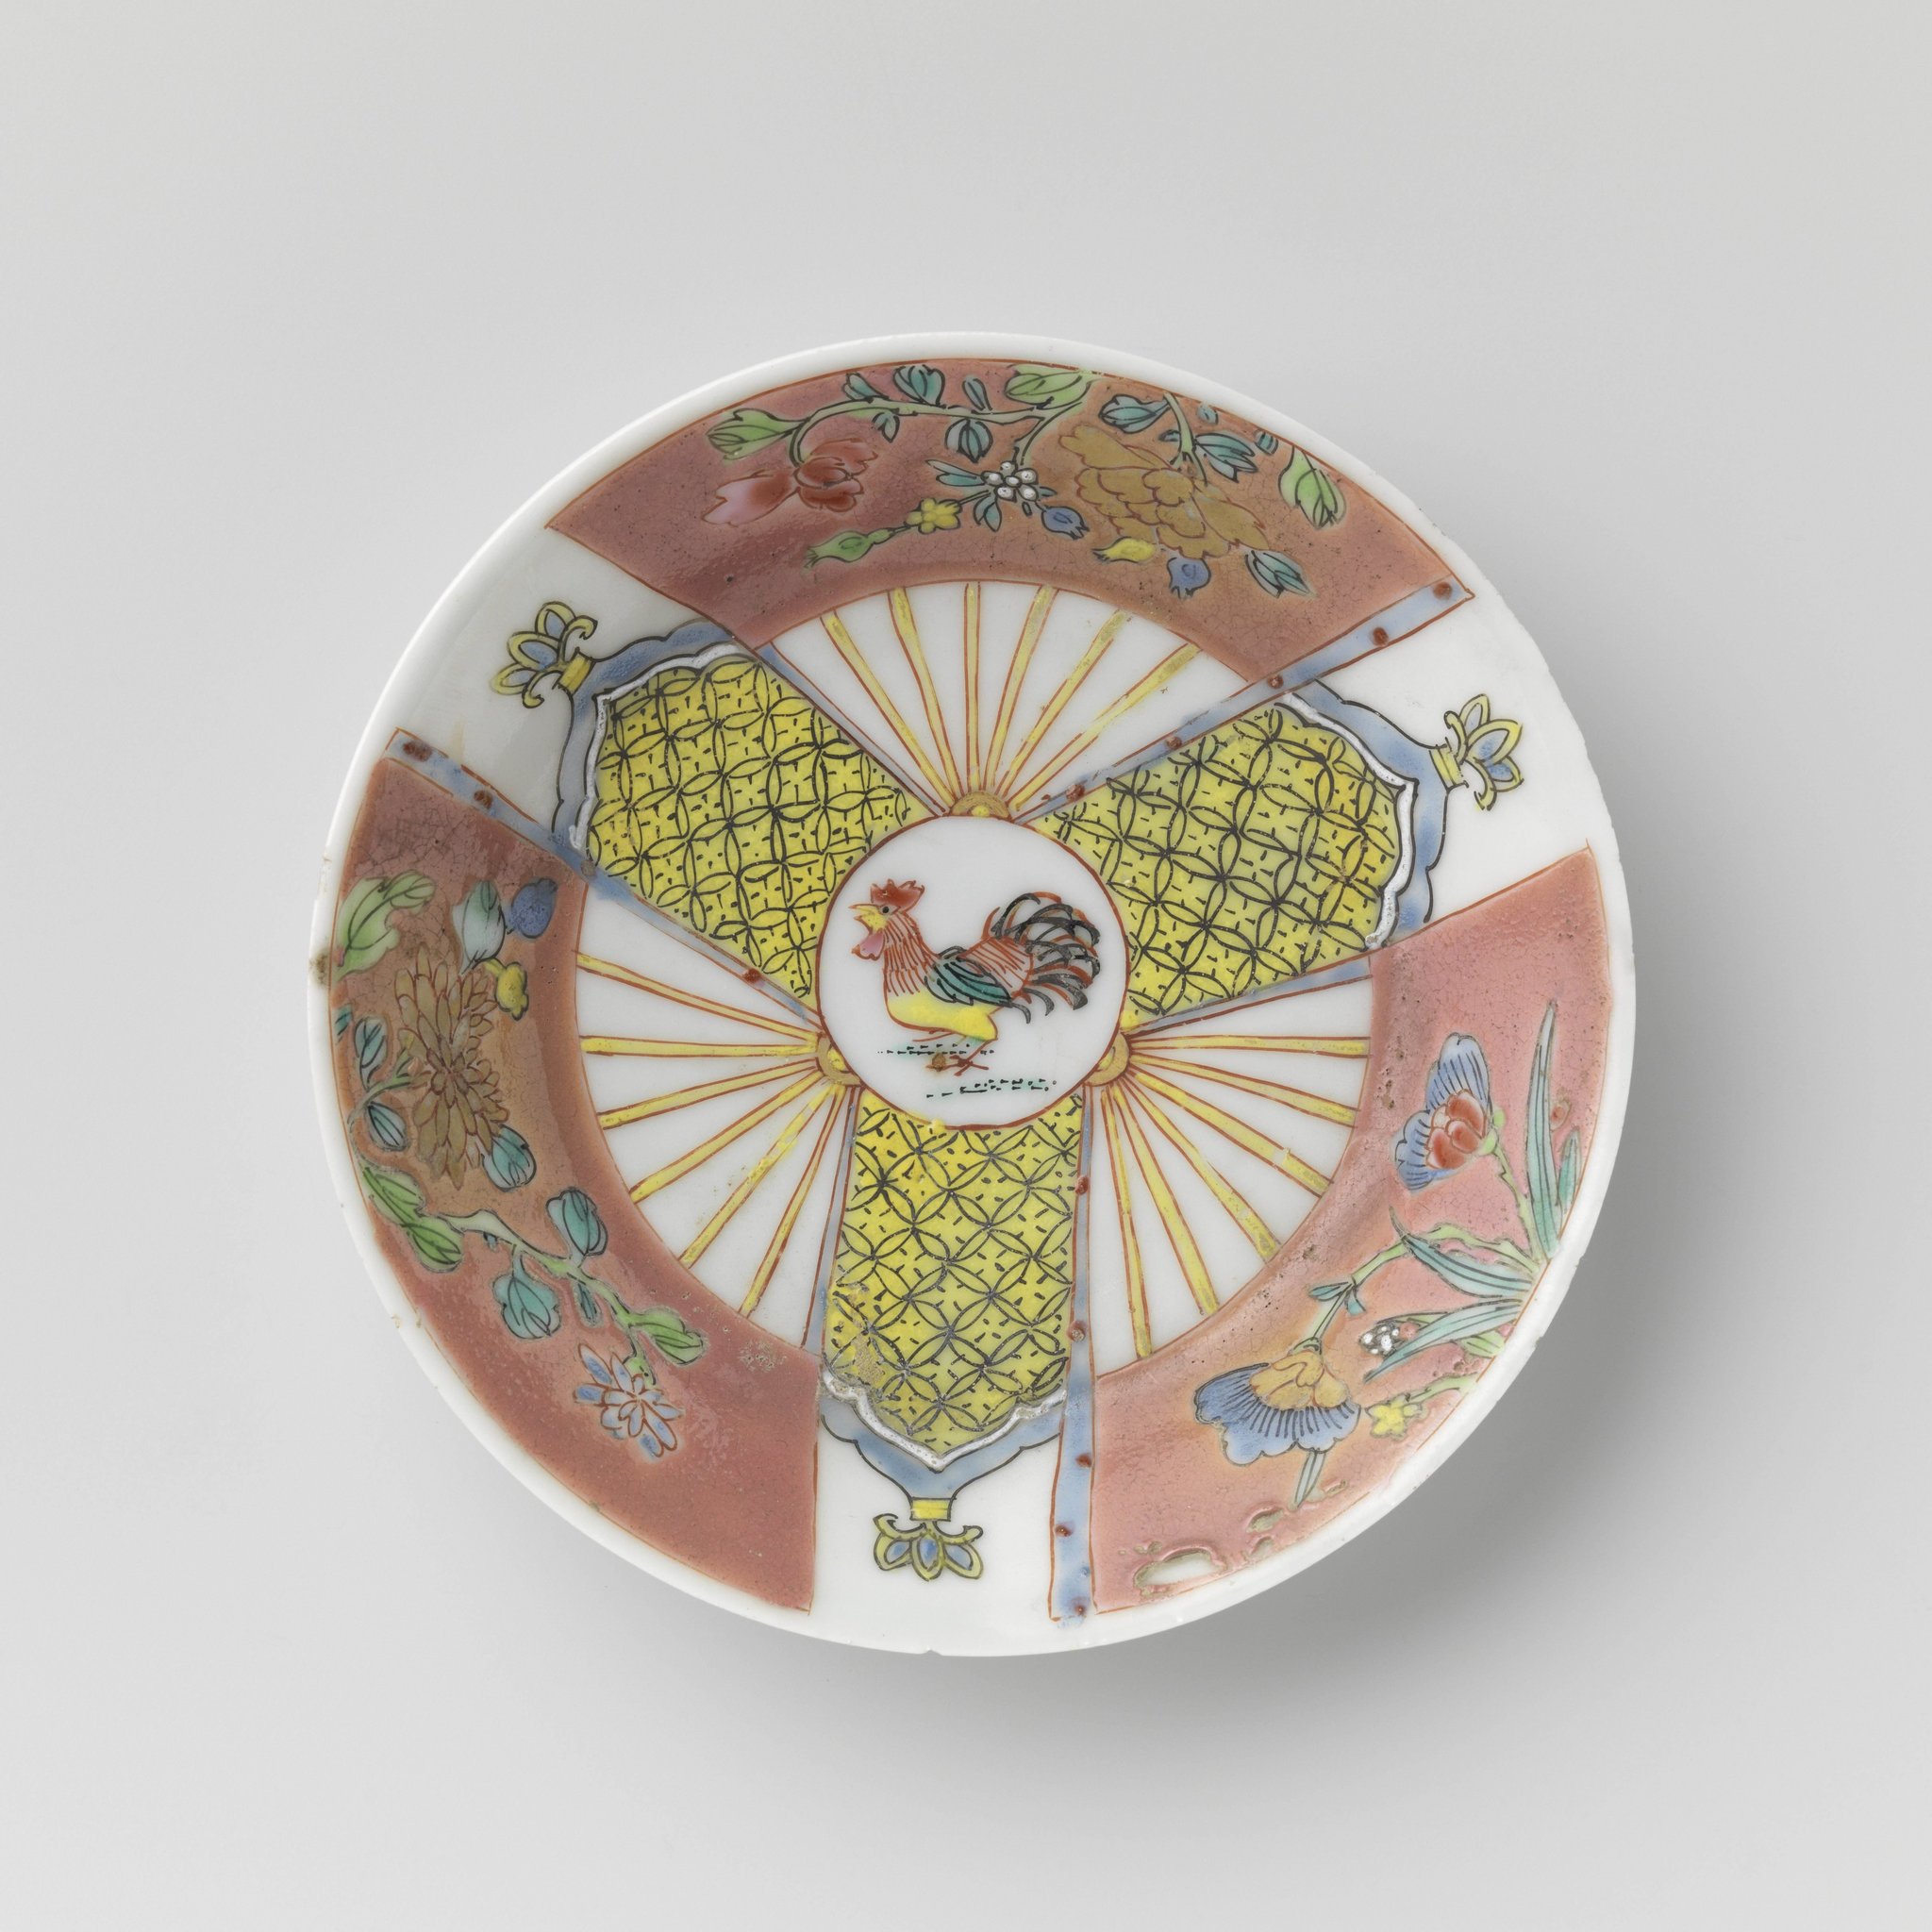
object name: kop en schotel, kop en schotel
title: Saucer with cock and three fans with flower sprays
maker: Anonymous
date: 1725-1749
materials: glaze, gold, paint, porcelain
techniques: firing, gilding, turning, vitrification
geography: china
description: Kop en schotel, famille rose versierd met haantjes en waaiers.